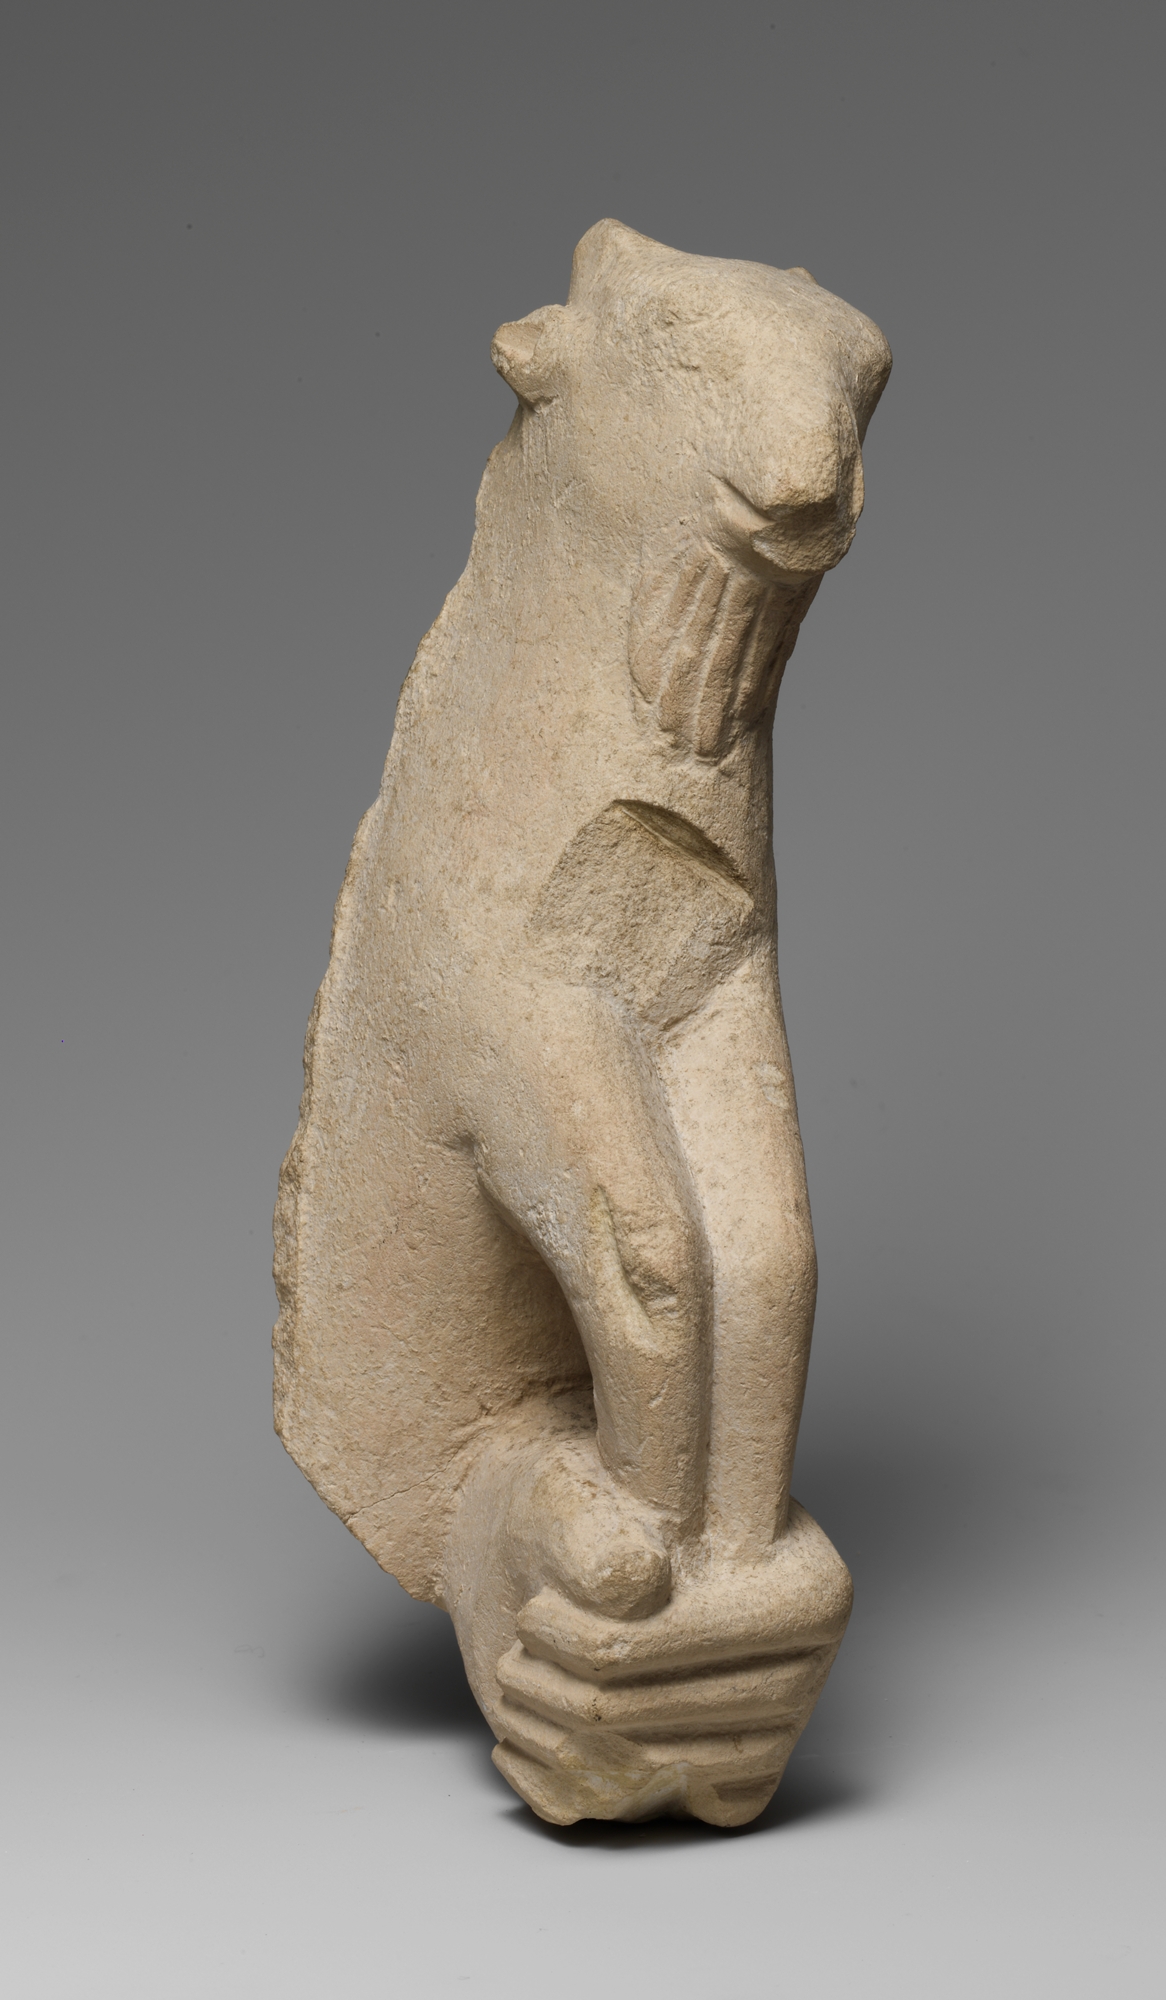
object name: statue fragment of a left hand holding a kid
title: Limestone statue fragment of a left hand holding a kid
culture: cypriot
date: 500-450 BCE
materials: limestone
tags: hands,goats